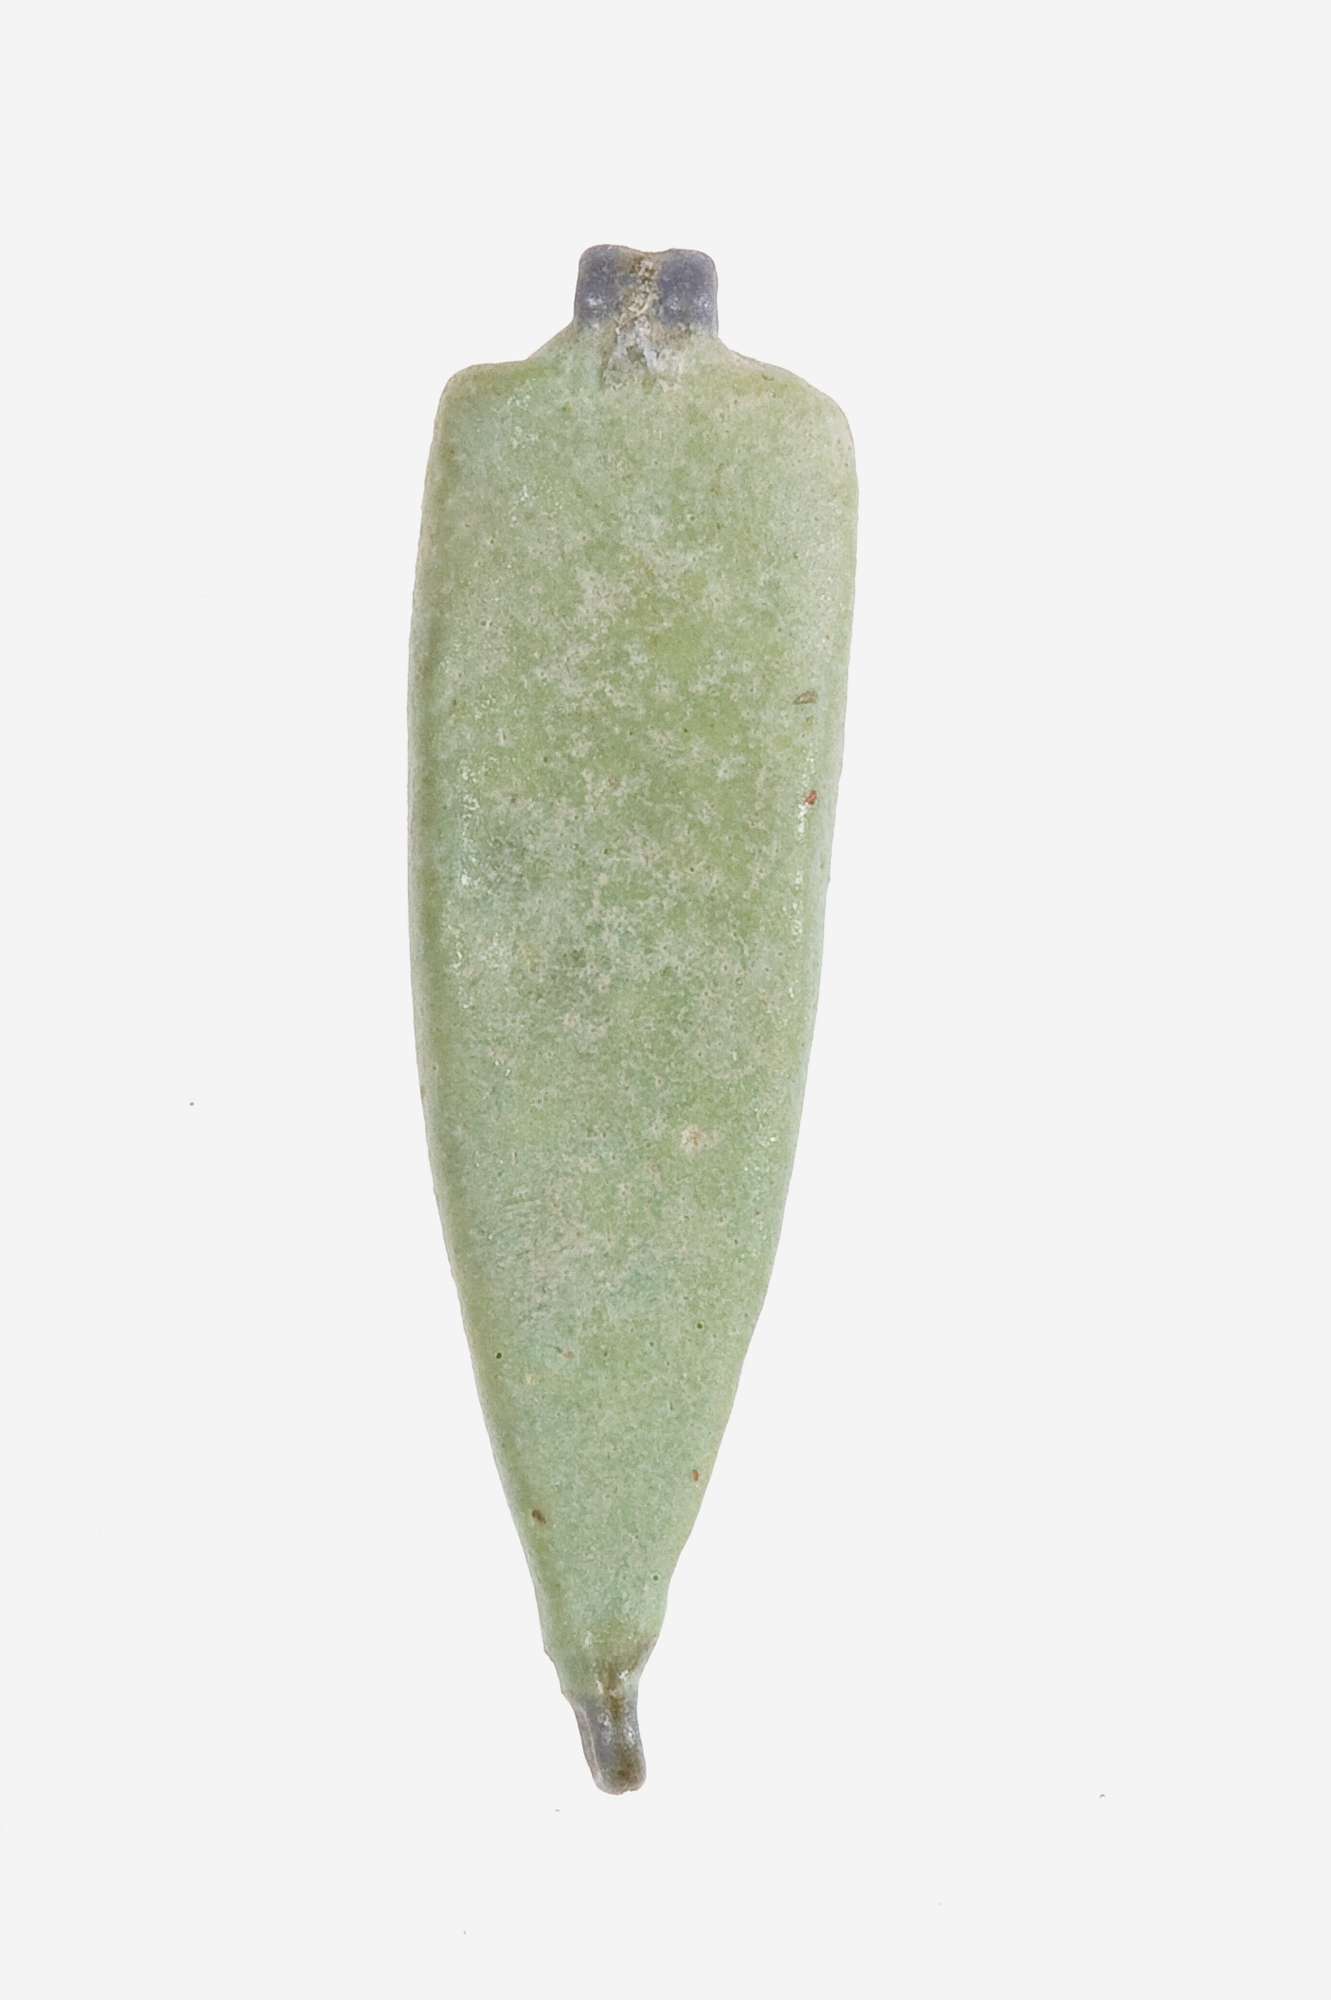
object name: pendant, leaf petal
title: Pendant: Lotus Sepal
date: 1390-1352 BCE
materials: faience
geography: egypt